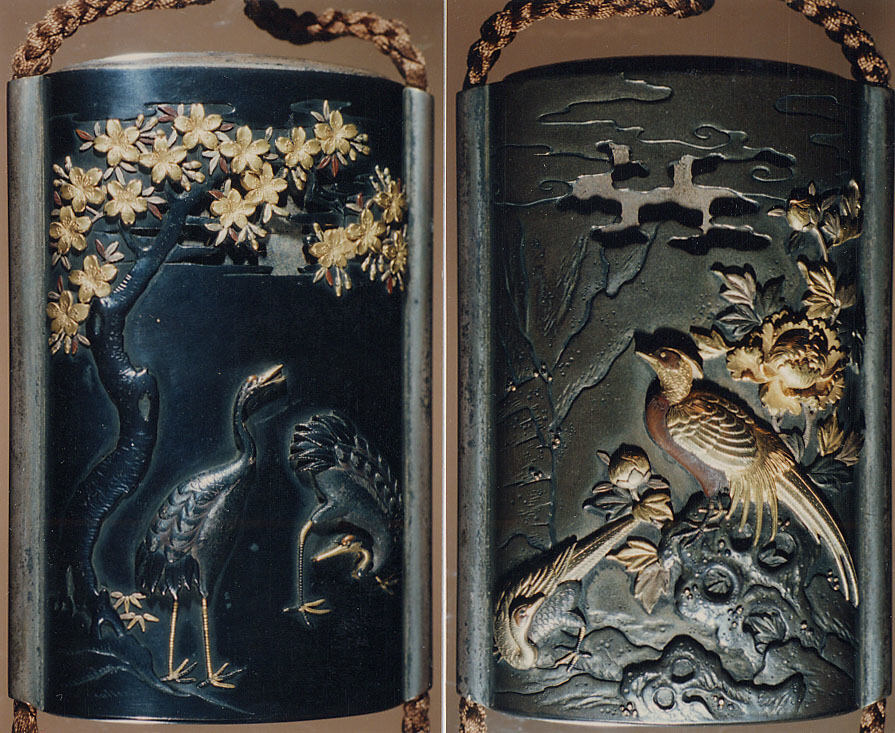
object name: inrō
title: Case (Inrō) with Design of Two Cranes beneath a Flowering Cherry (obverse); Pheasant beside a Peony (reverse)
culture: japanese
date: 1801-1900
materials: gold, metal, metal alloy, silver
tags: cranes,pheasants,peonies,trees